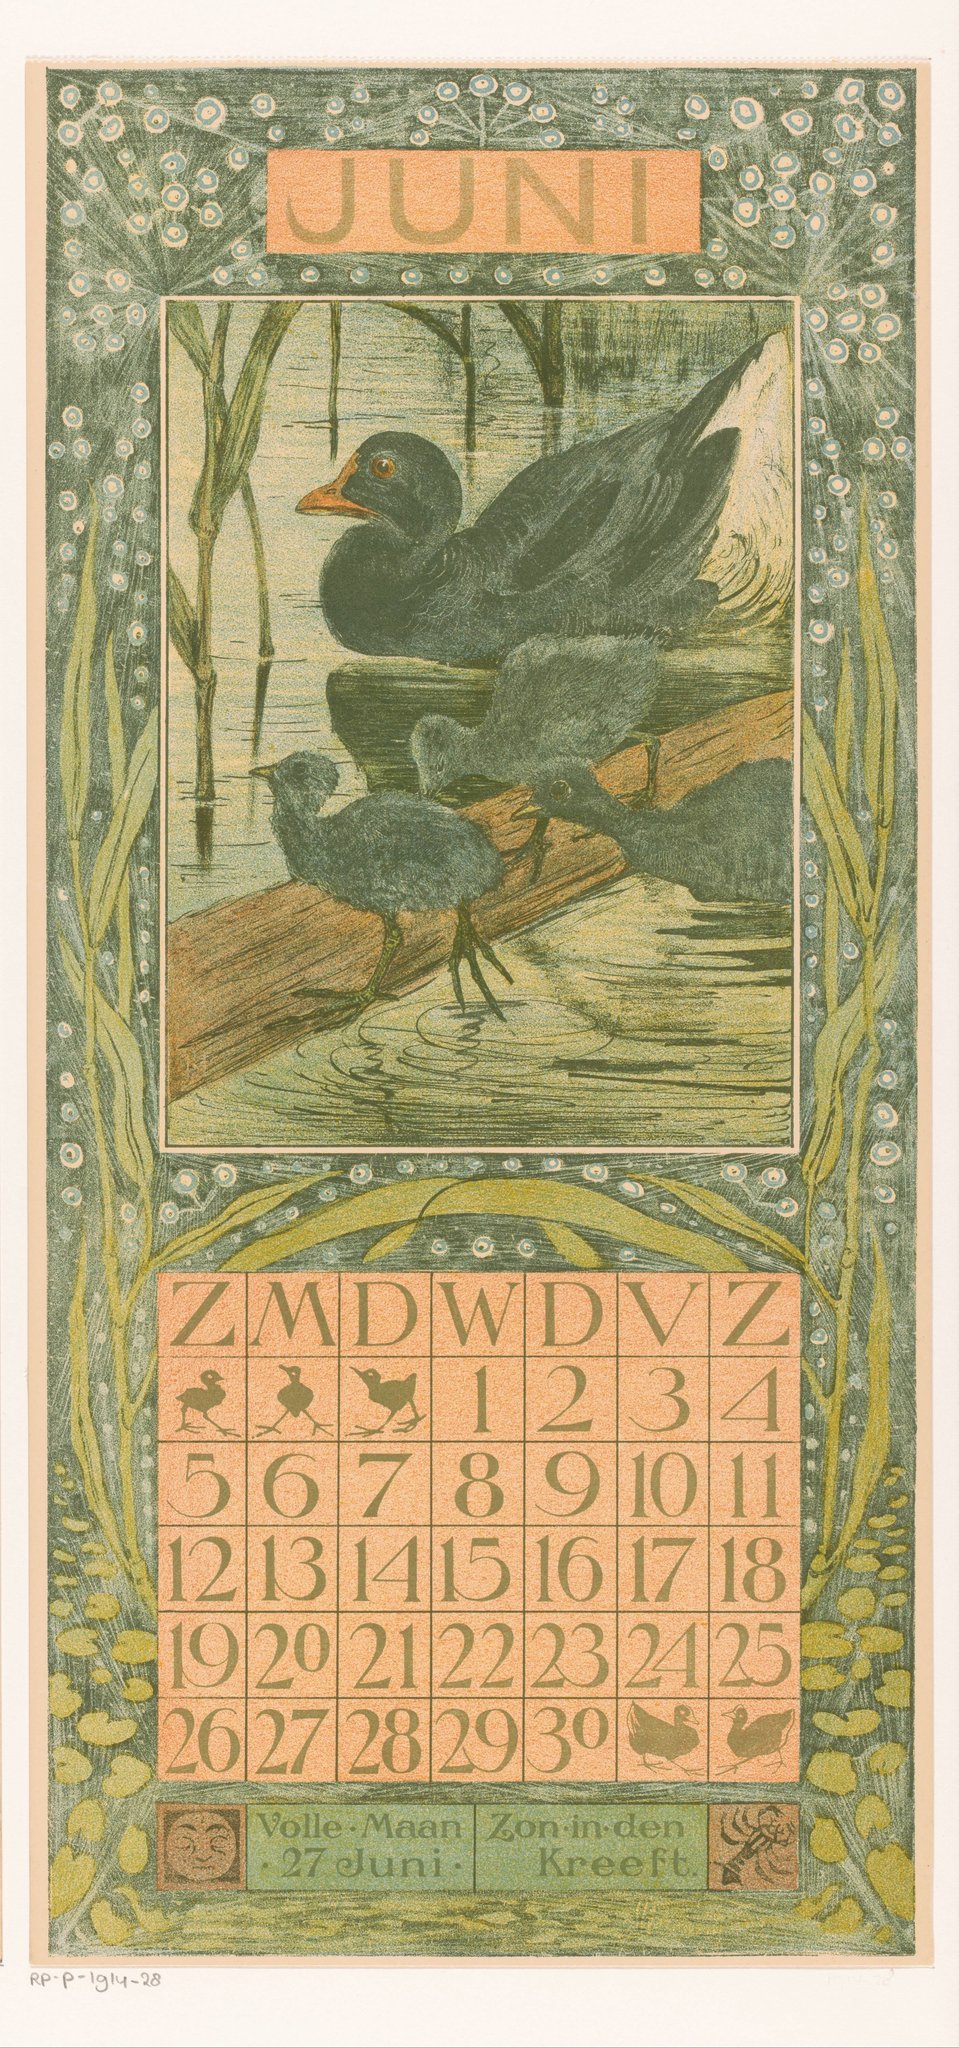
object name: print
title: Kalender 1904 12 lithografien door Th. v. Hoytema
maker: theo van hoytema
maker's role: draughtsman, painter, print maker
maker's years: 1863-1917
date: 1903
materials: paper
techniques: lithograph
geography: amsterdam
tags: cancer (zodiacal sign of june), full moon represented as face, water-birds: duck, june ~ other concepts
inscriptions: collector's mark: Lugt 2228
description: Onder de data een volle maan en het sterrenbeeld Kreeft. Bovenaan het blad een scheurlijn.